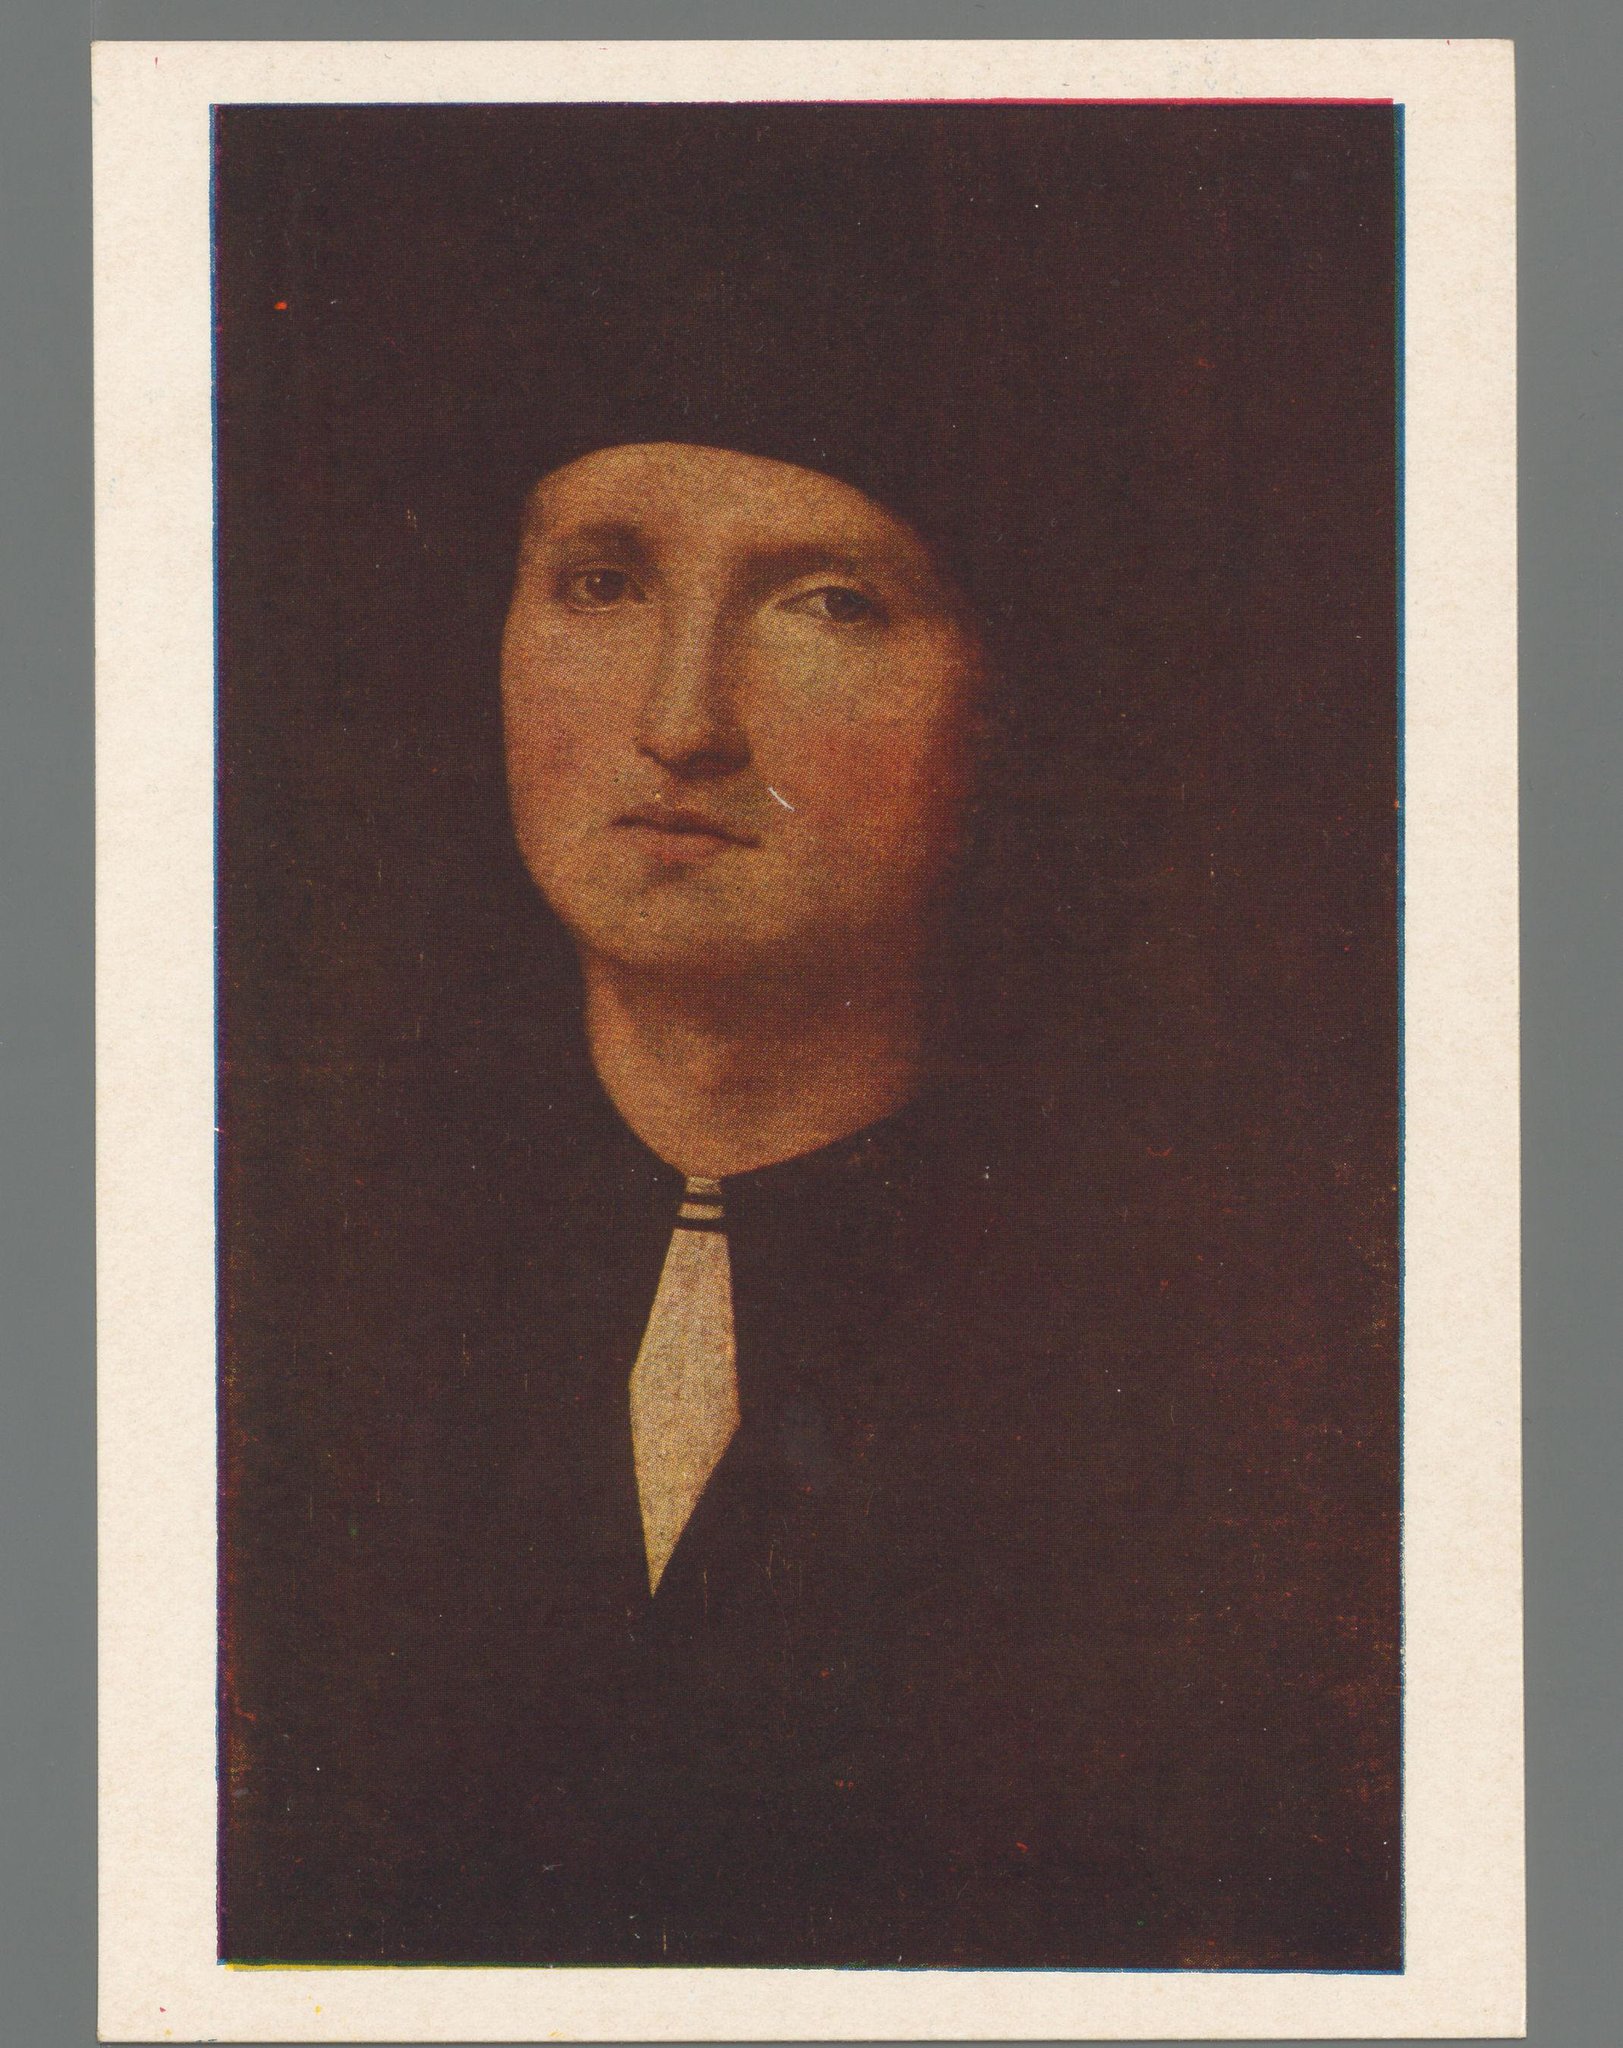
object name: reproduction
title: Le Pérugin (Pietro Vanucci, dit). Portrait d'homme / Pietro Perugino. Portrait of a man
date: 1956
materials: cardboard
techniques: color autotype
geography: moscow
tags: permanent exhibition, museum, picture, painting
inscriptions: date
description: De titel op object staat ook in het Russisch.